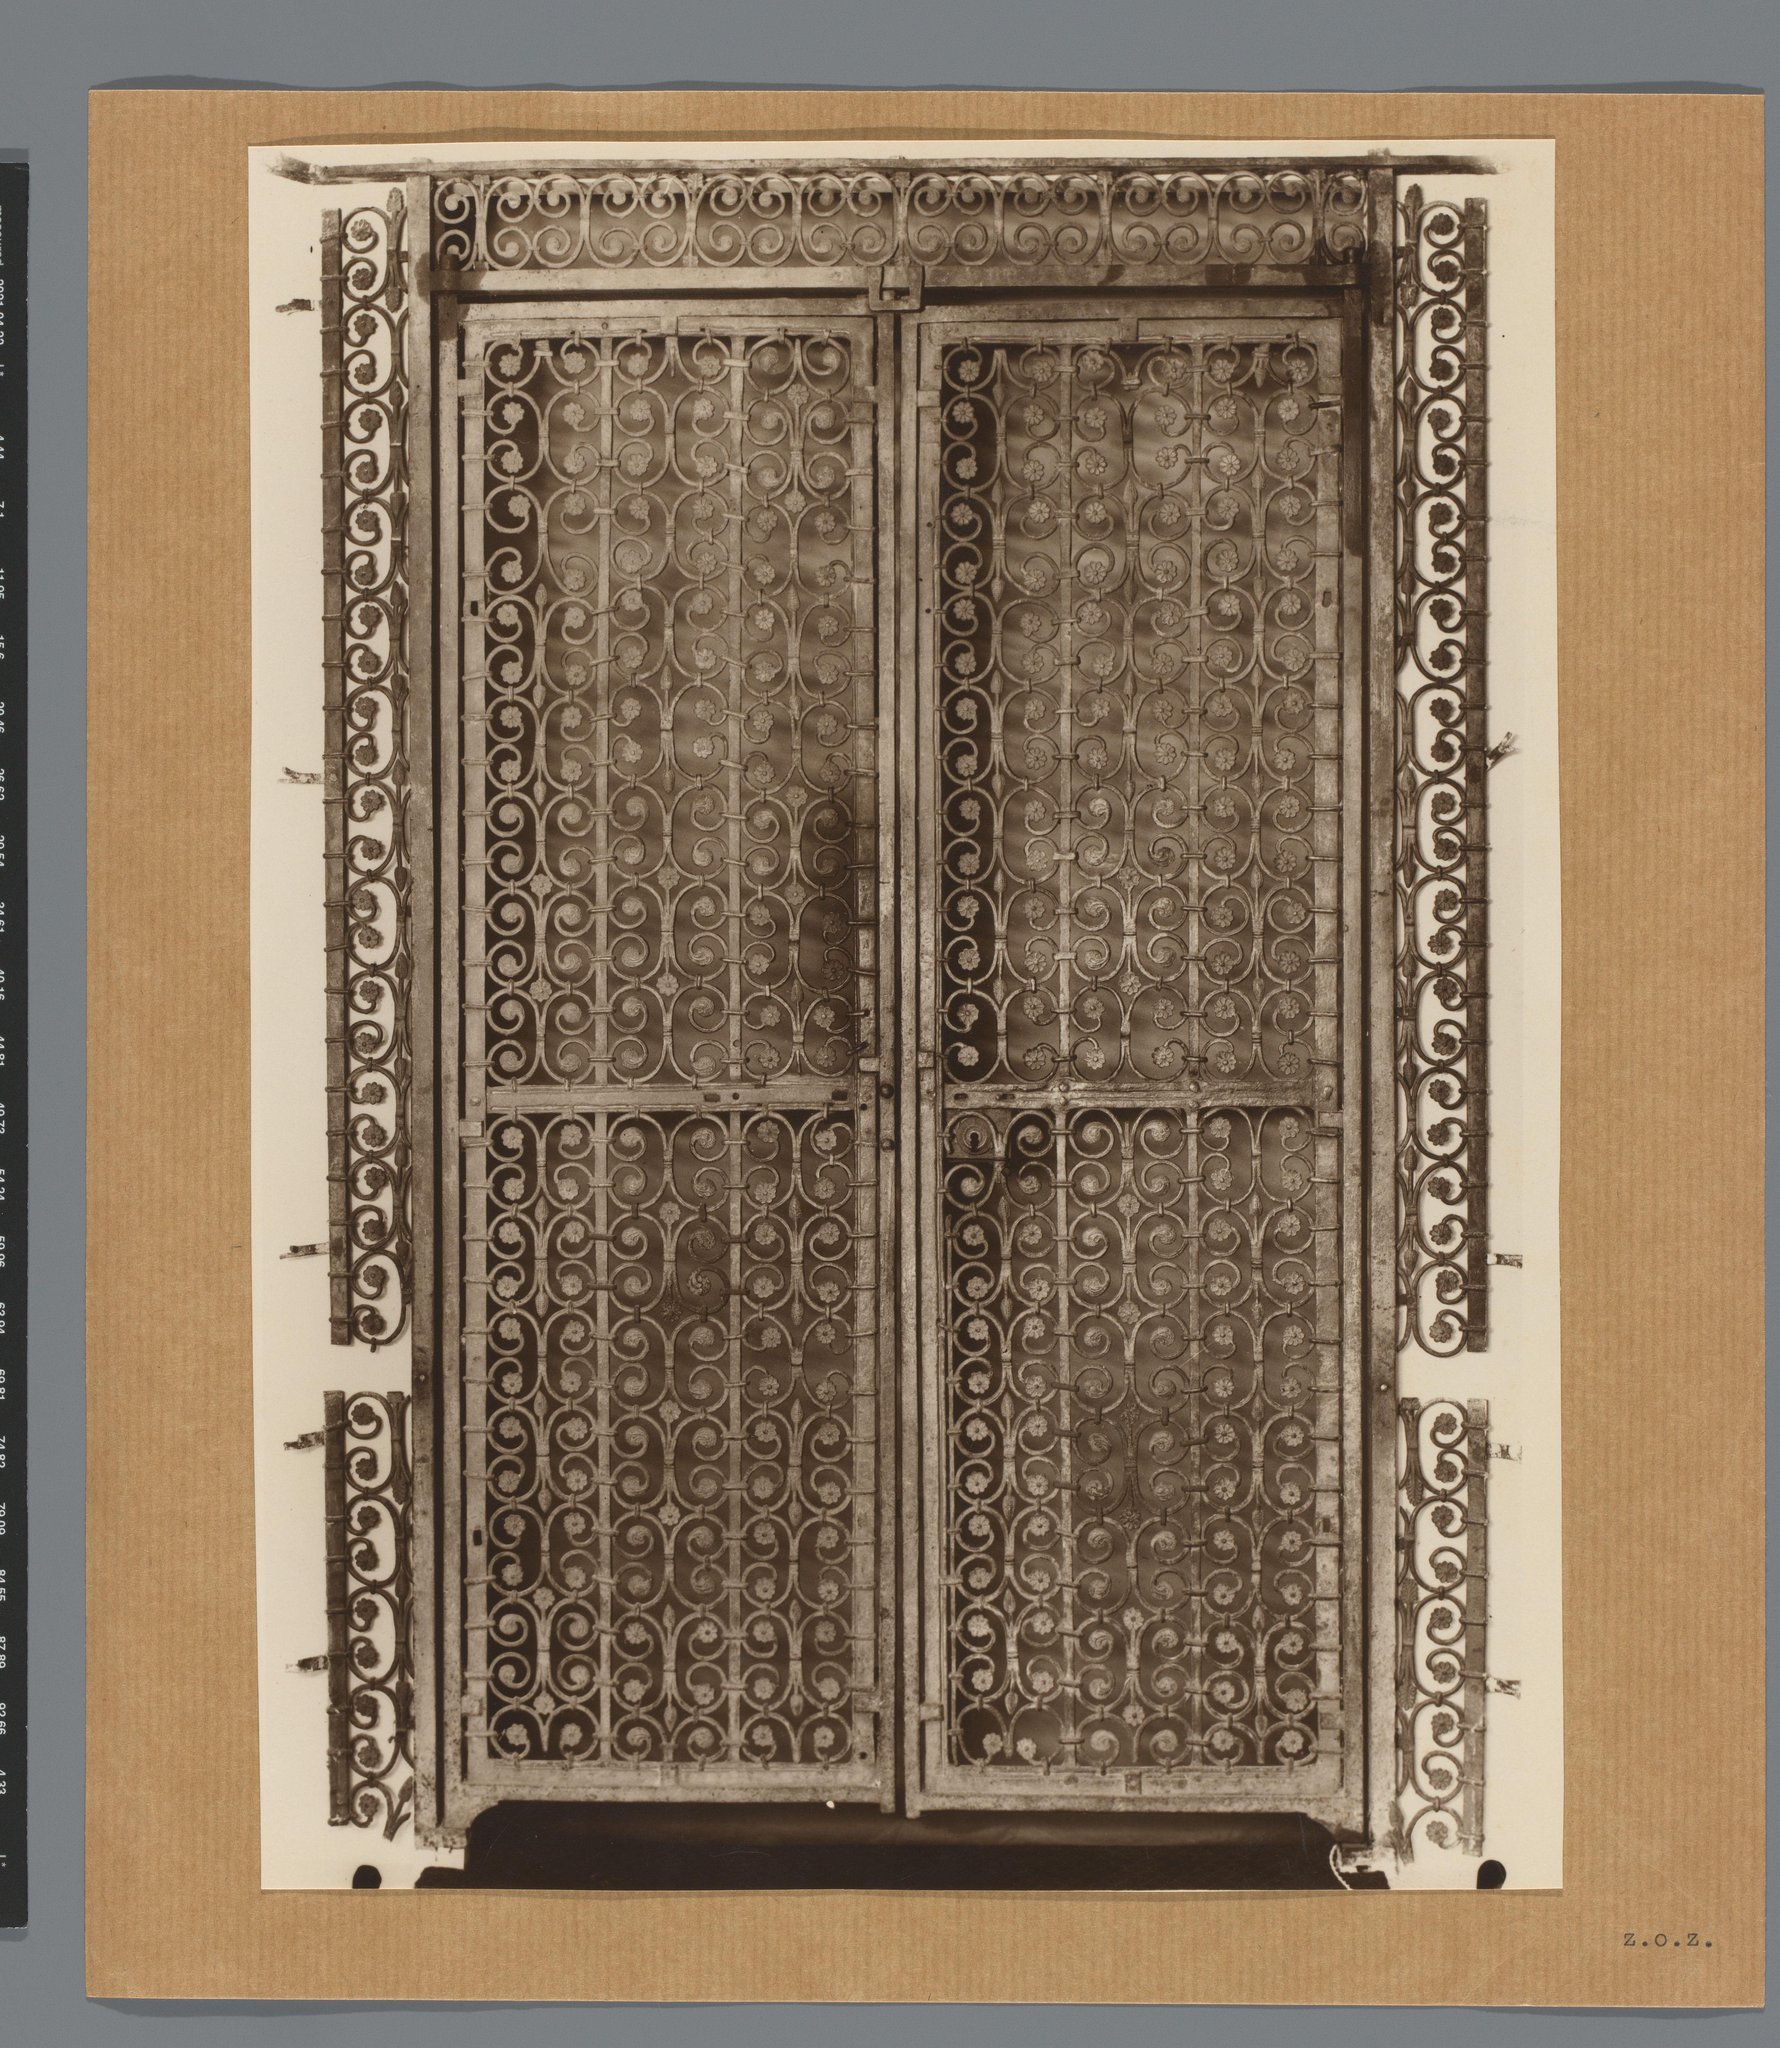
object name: photograph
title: Compiegne. Raadhuis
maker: Anonymous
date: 1850-1880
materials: photographic support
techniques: albumen print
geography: france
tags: compiègne